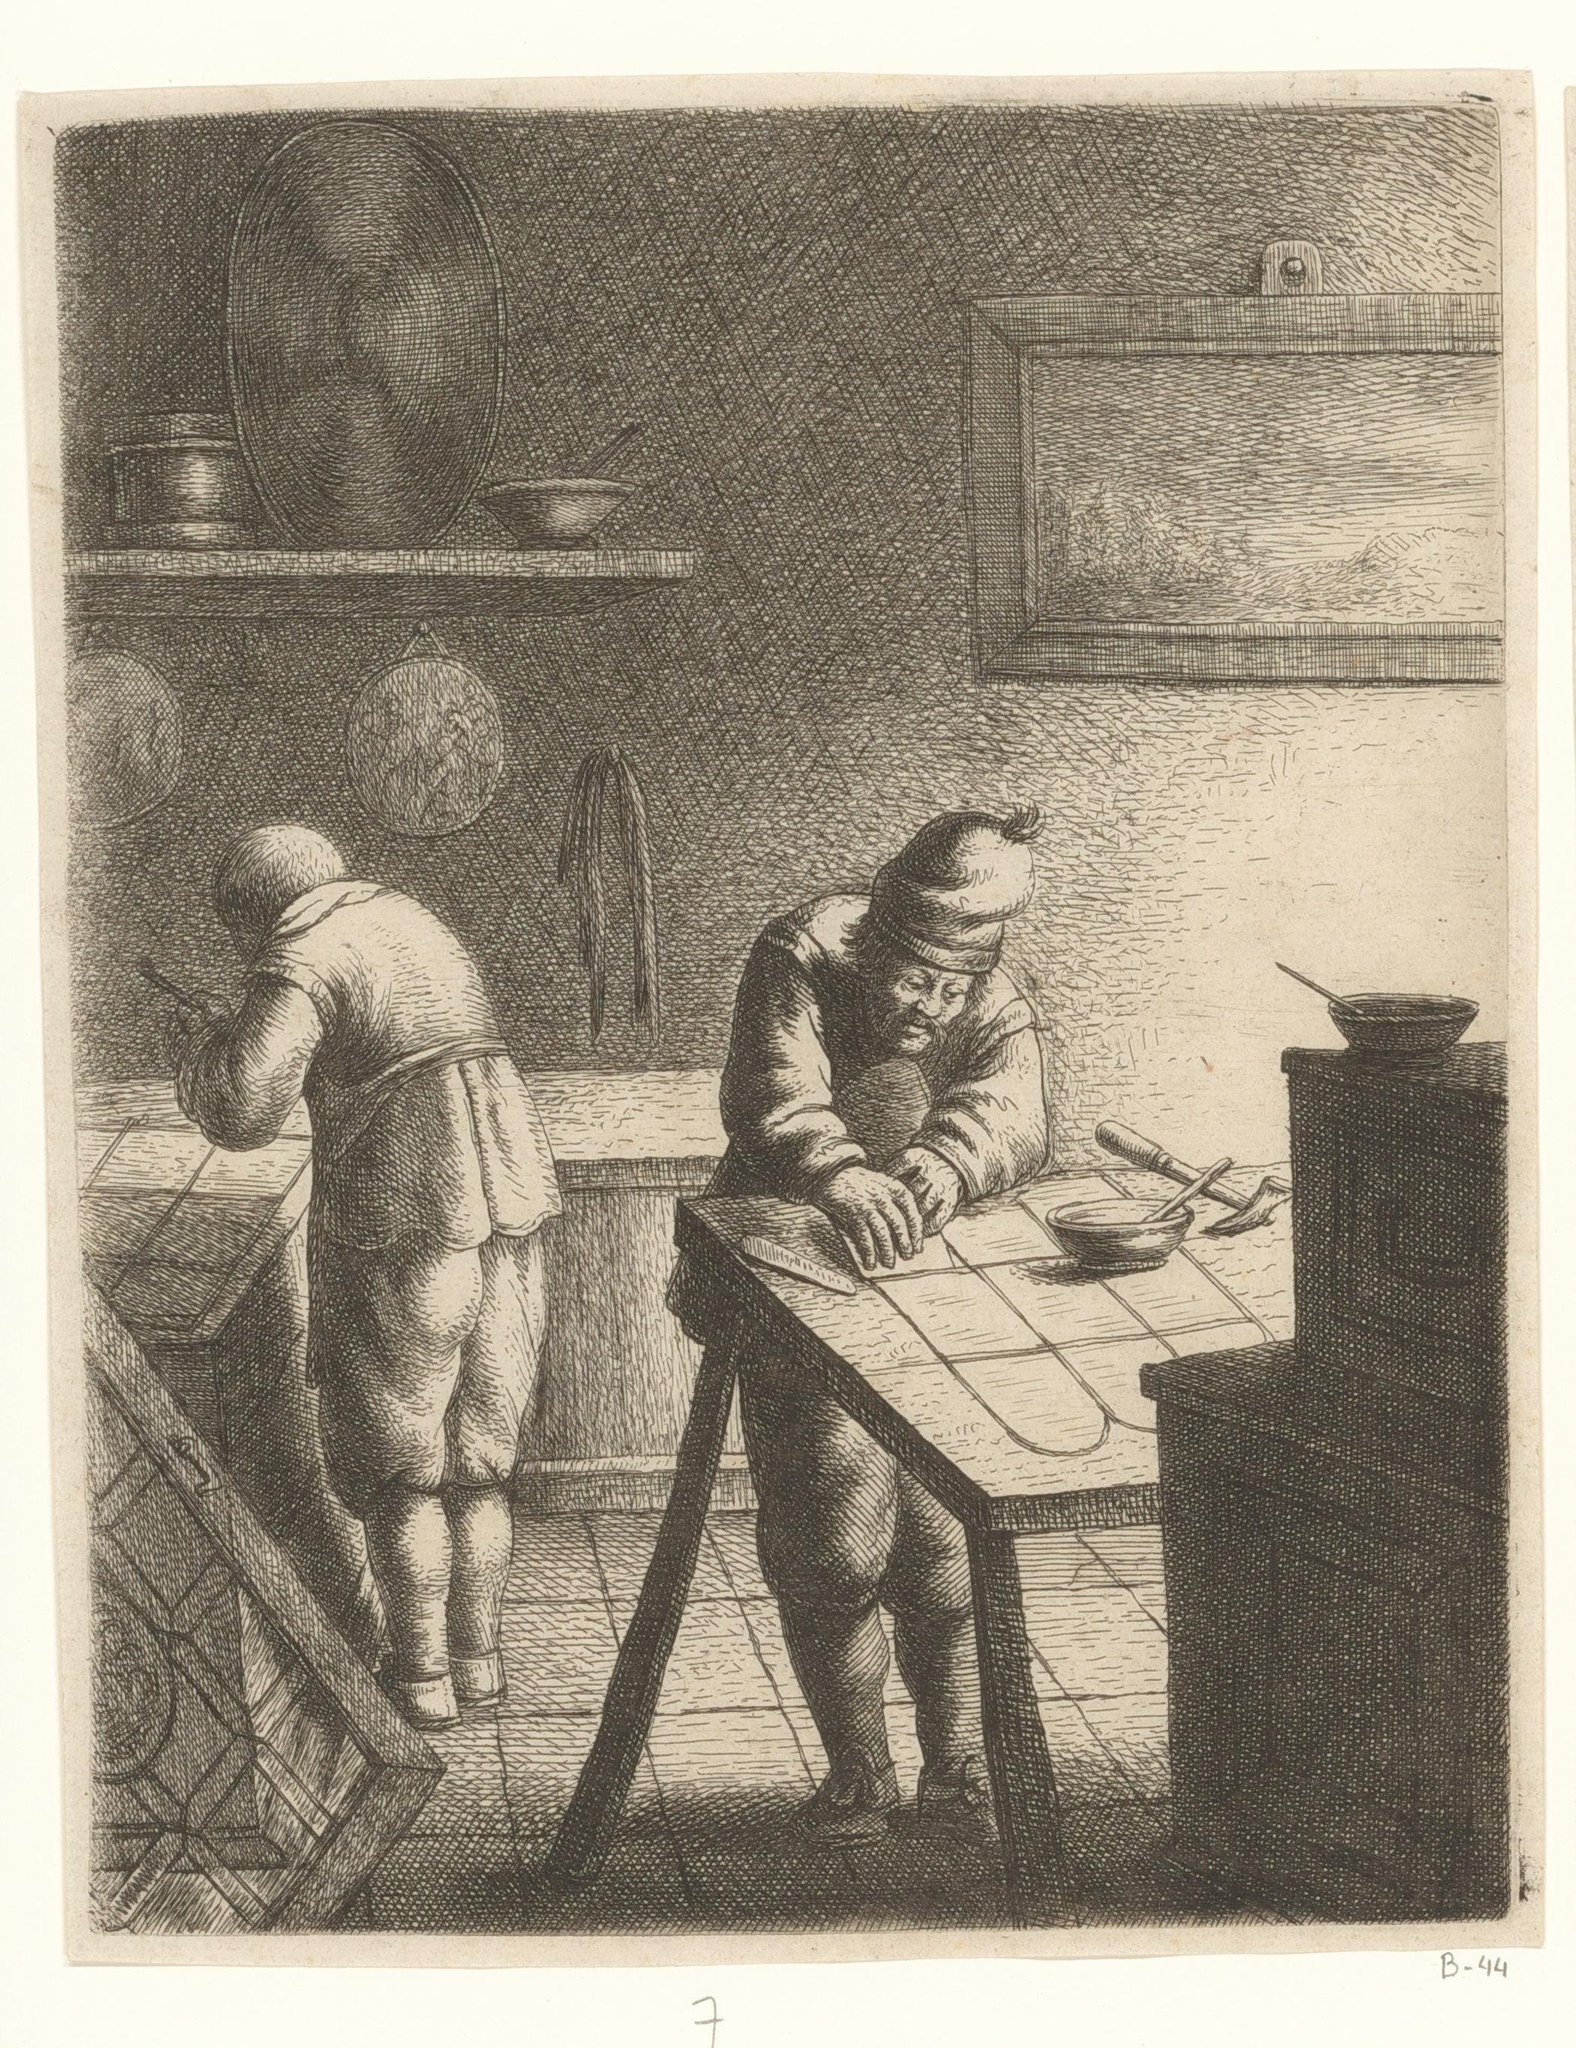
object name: print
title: Beroepen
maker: jan gillisz. van vliet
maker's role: draughtsman, painter, print maker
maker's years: 1600-1668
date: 1635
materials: paper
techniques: etching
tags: glass-maker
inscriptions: stamp, collector's mark: Lugt 1641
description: Een man snijdt glas voor een glas-in-loodruit. Onderwerpsrubrieken binnen de Atlas Zeden en Gewoonten: Handel, Nijverheid en Verkeer, Beroep en bedrijf, Complete suites.